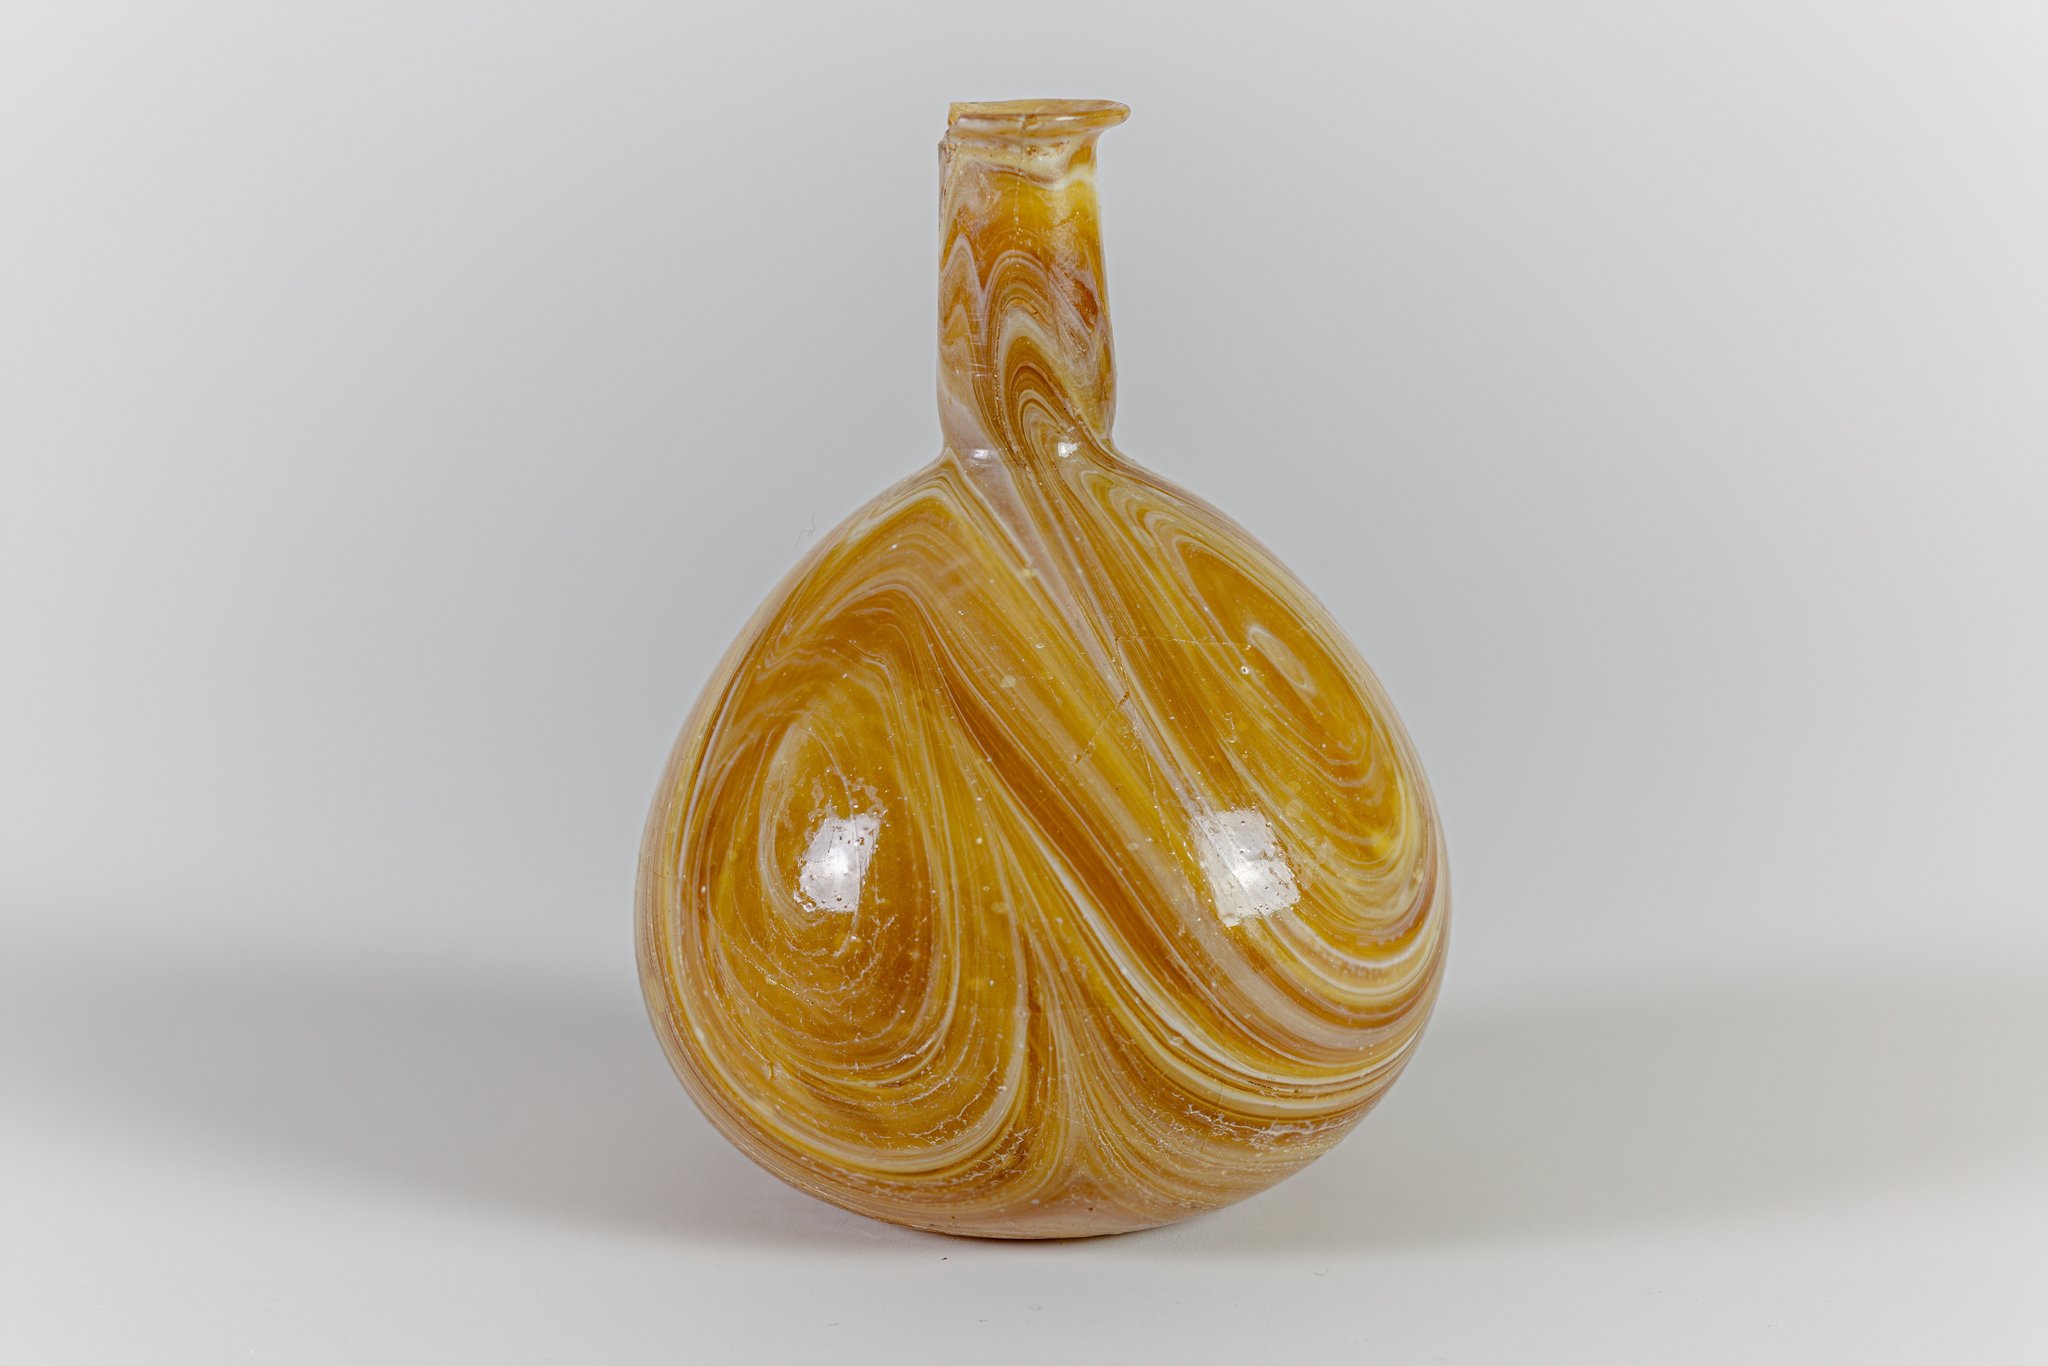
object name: perfume bottle, mosaic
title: Glass mosaic perfume bottle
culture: roman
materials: glass